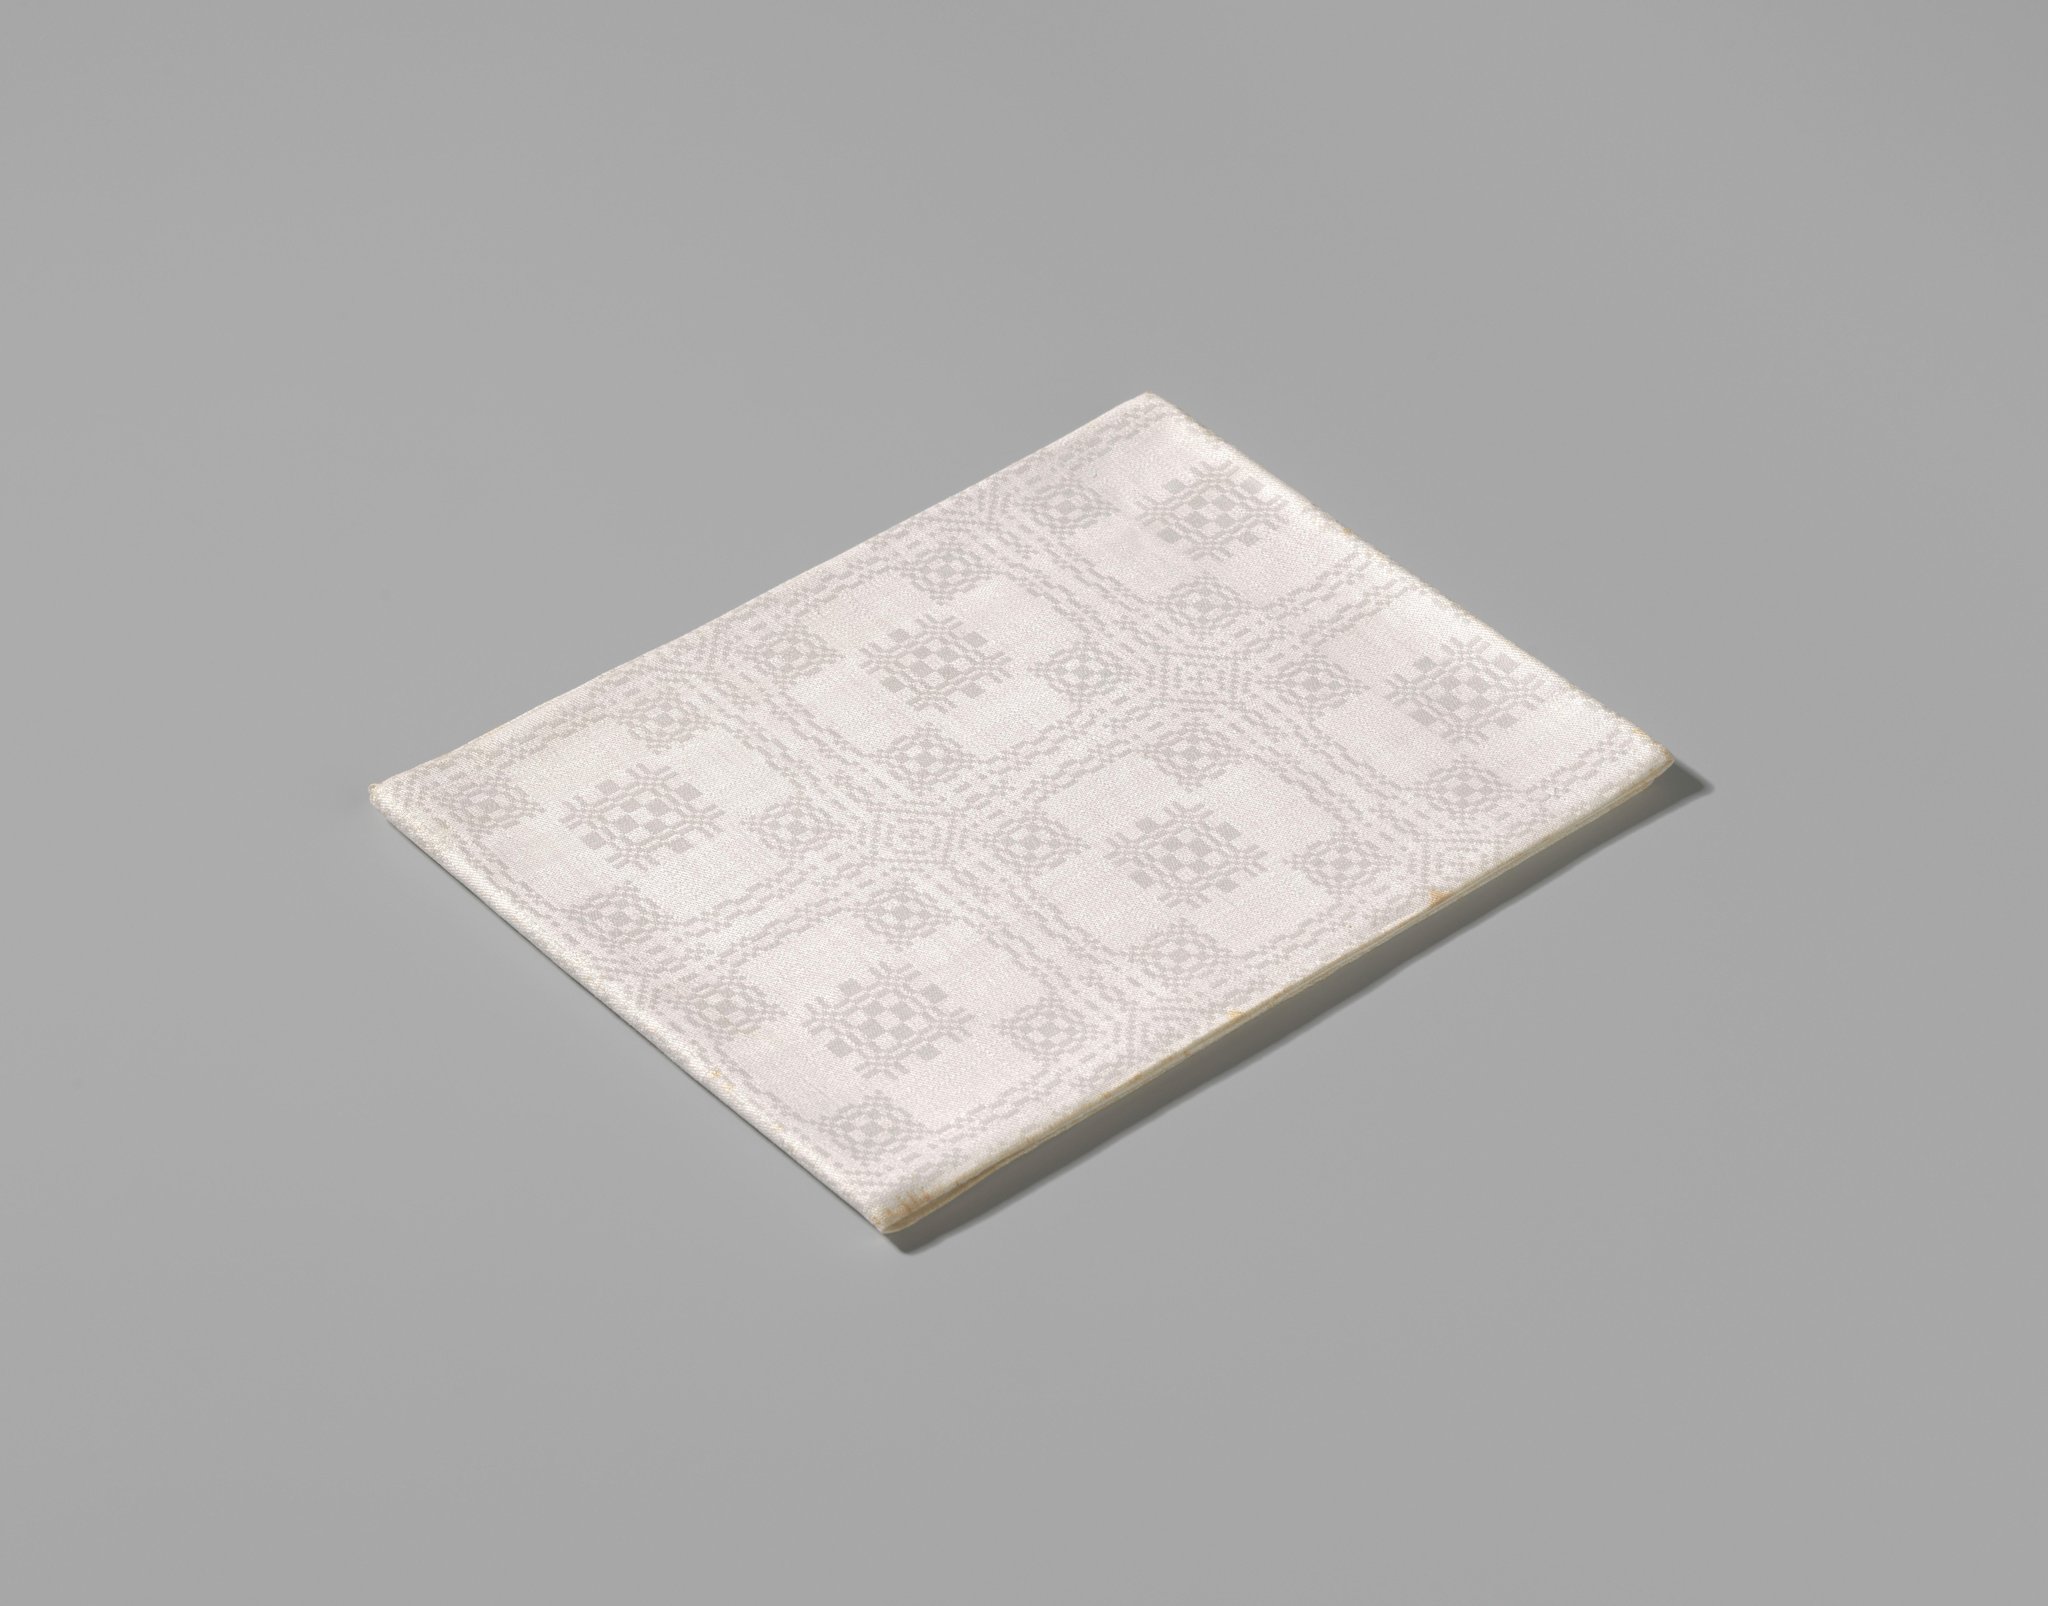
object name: napkin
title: Servet van linnen met pellenpatroon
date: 1690-1710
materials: linen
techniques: peeled fabric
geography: netherlands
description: wit linnen servet met een pellen patroon, merk IGS 37 WH 2oonl